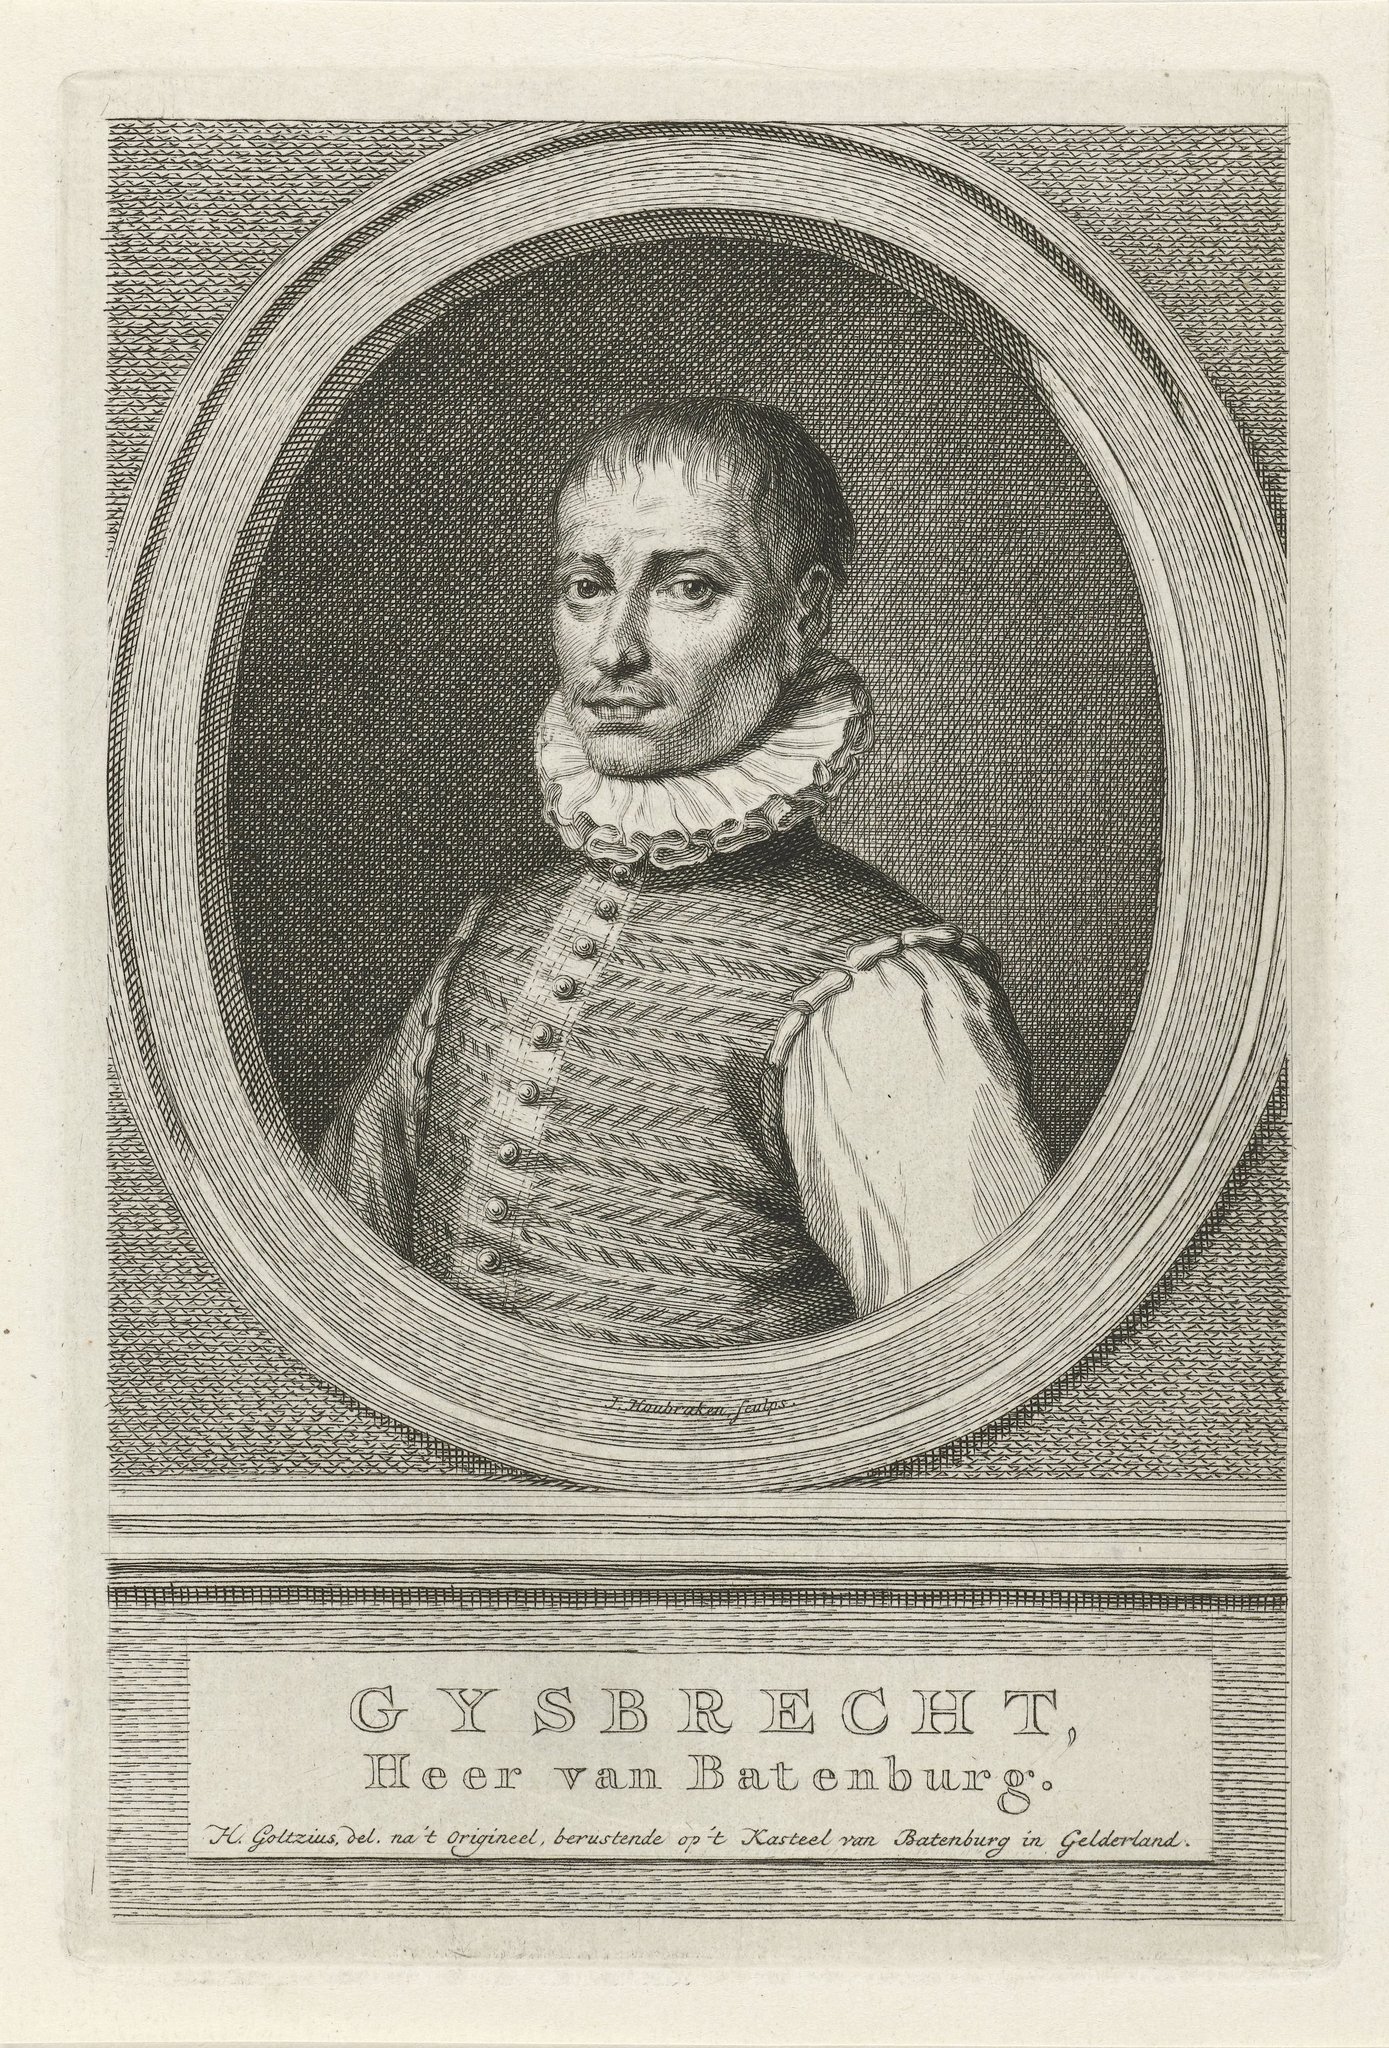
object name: print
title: Portret van Gijsbert van Bronckhorst en Batenburg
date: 1749-1759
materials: paper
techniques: engraving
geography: amsterdam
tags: gijsbert van bronckhorst en batenburg, verbond der edelen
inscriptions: collector's mark: Lugt 2228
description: Prent oorspronkelijk bedoeld voor: Jan Wagenaar, Vaderlandsche historie, vervattende de geschiedenissen der nu Vereenigde Nederlanden, inzonderheid die van Holland (...), 21 delen. Amsterdam, Isaak Tirion, 1749-59.